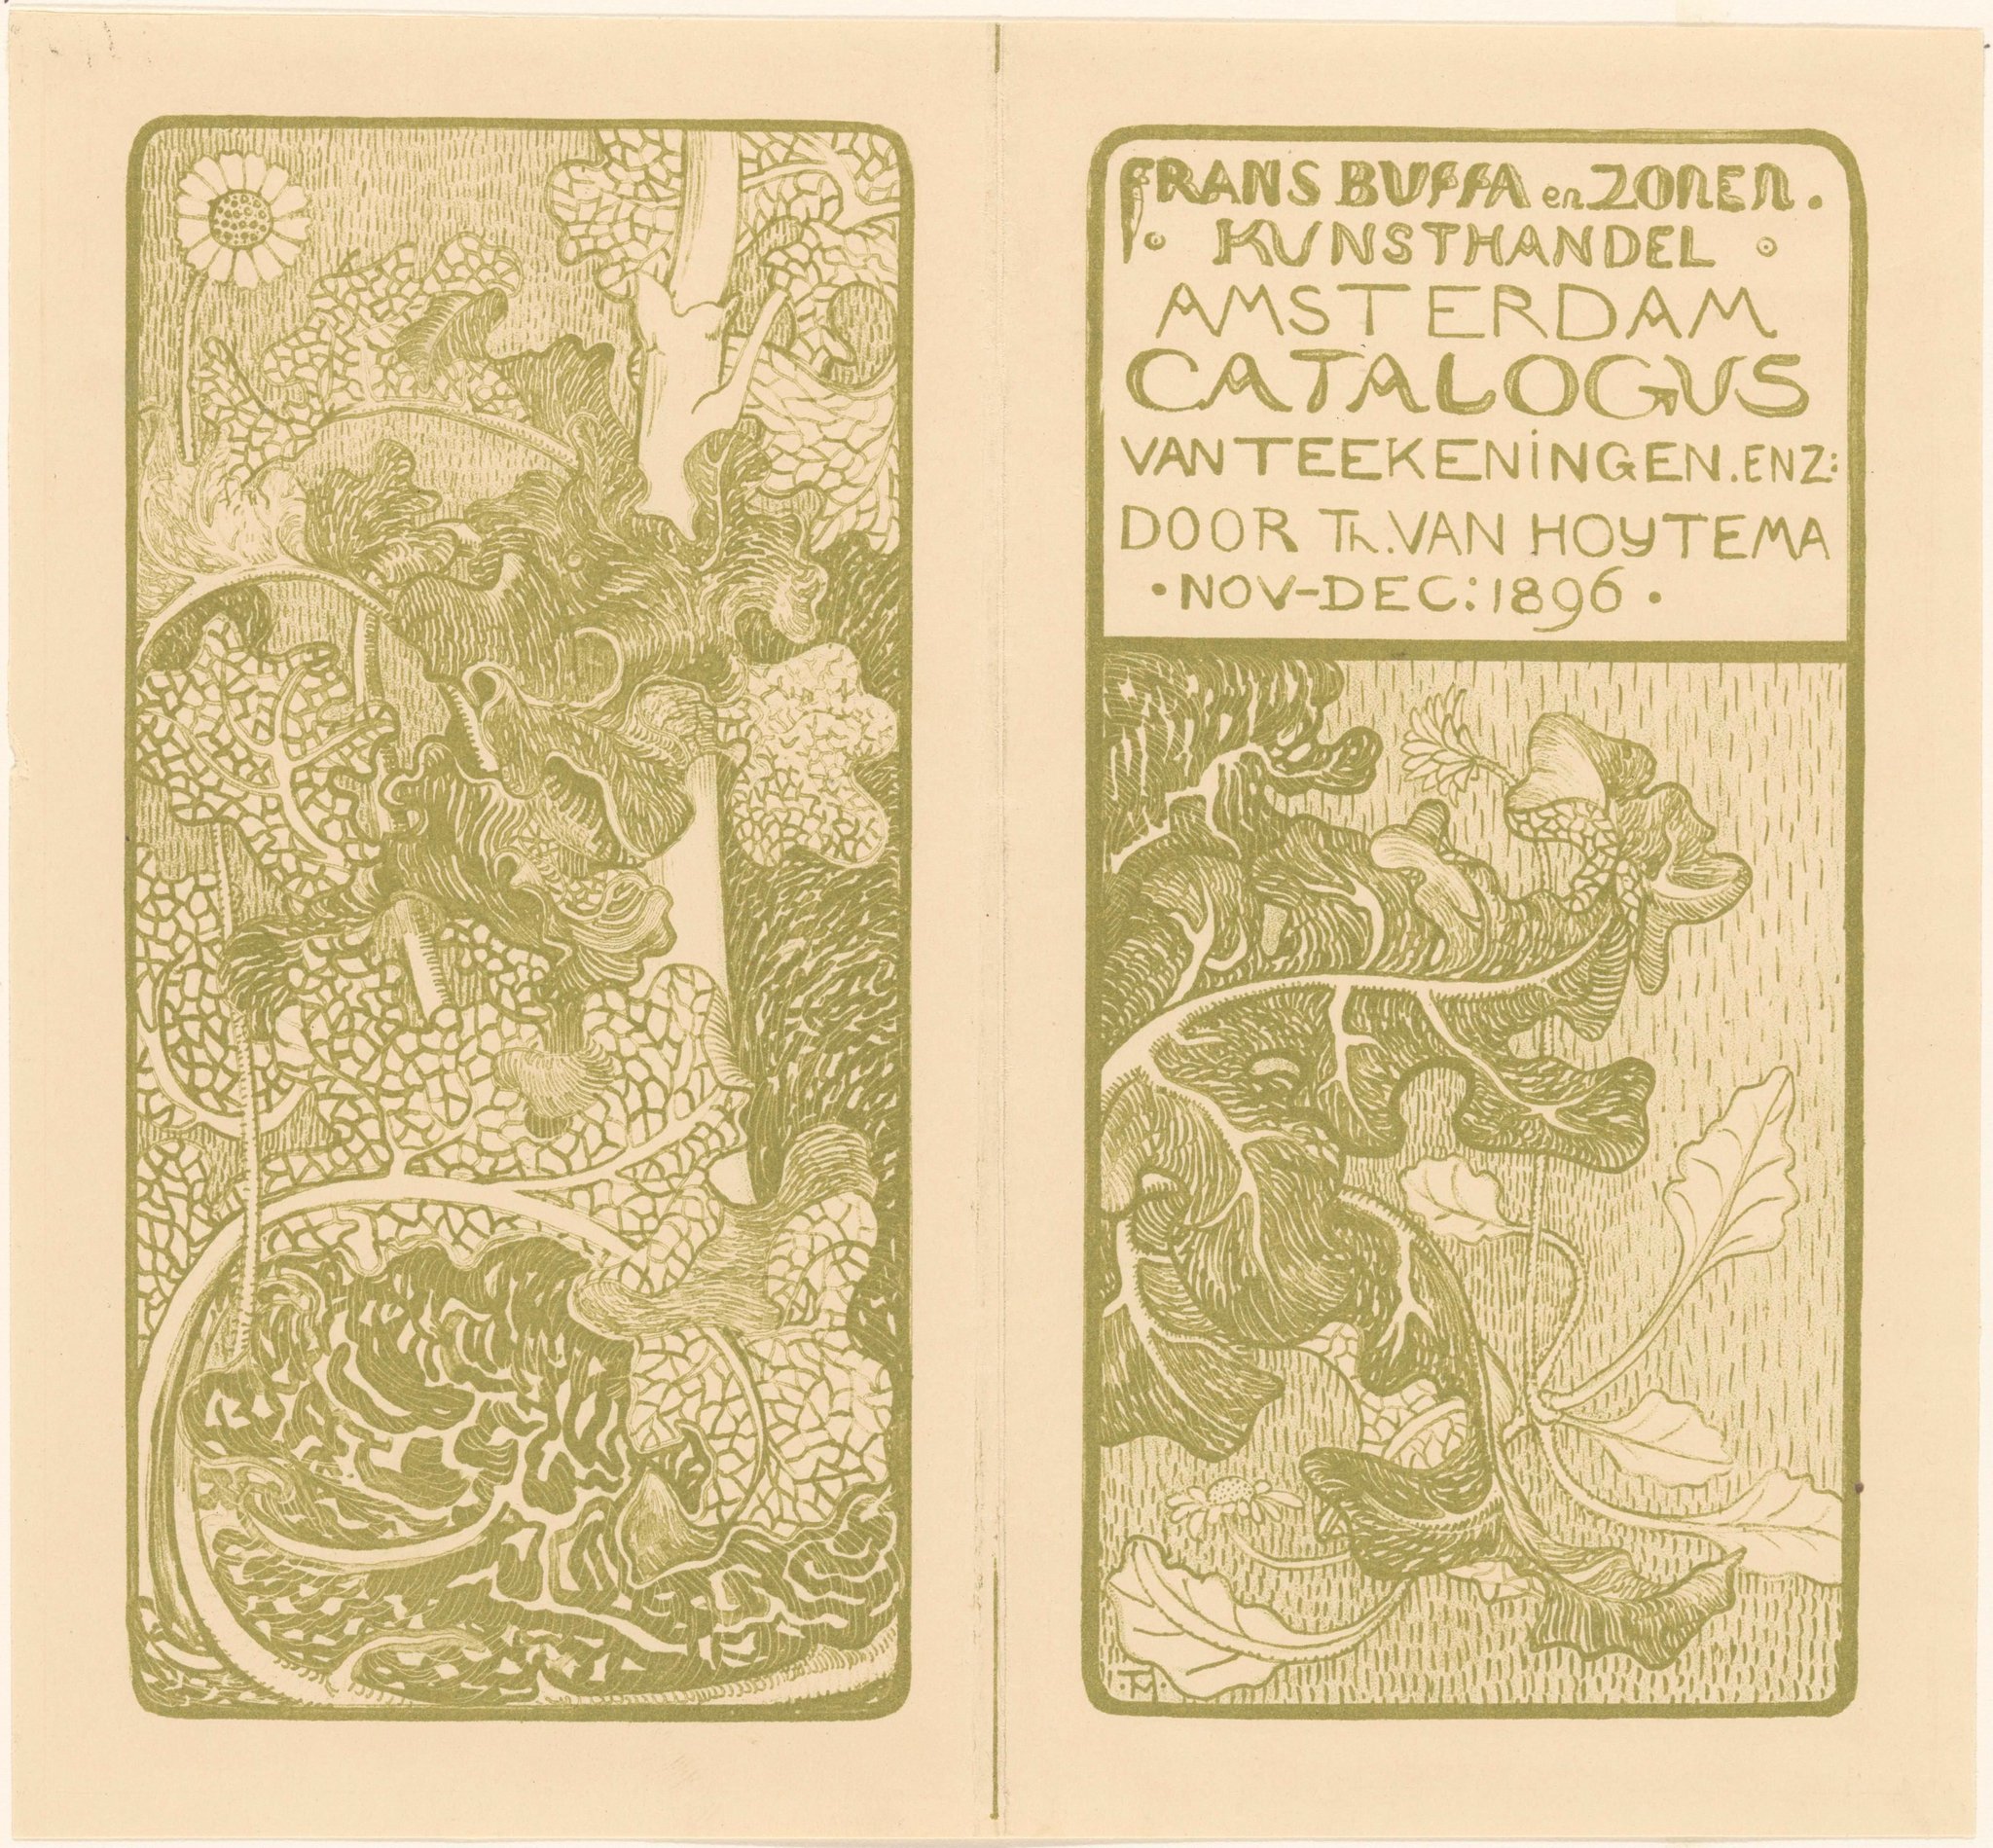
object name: print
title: Catalogusomslag met bladeren en bloemen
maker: theo van hoytema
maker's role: draughtsman, painter, print maker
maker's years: 1863-1917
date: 1811-1896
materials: paper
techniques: lithograph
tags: flowers, trees (+ leaf)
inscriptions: collector's mark: Lugt 2233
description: Catalogusomslag voor een tentoonstelling van tekeningen van Theo van Hoytema. Twee kaders met bladeren en bloemen.